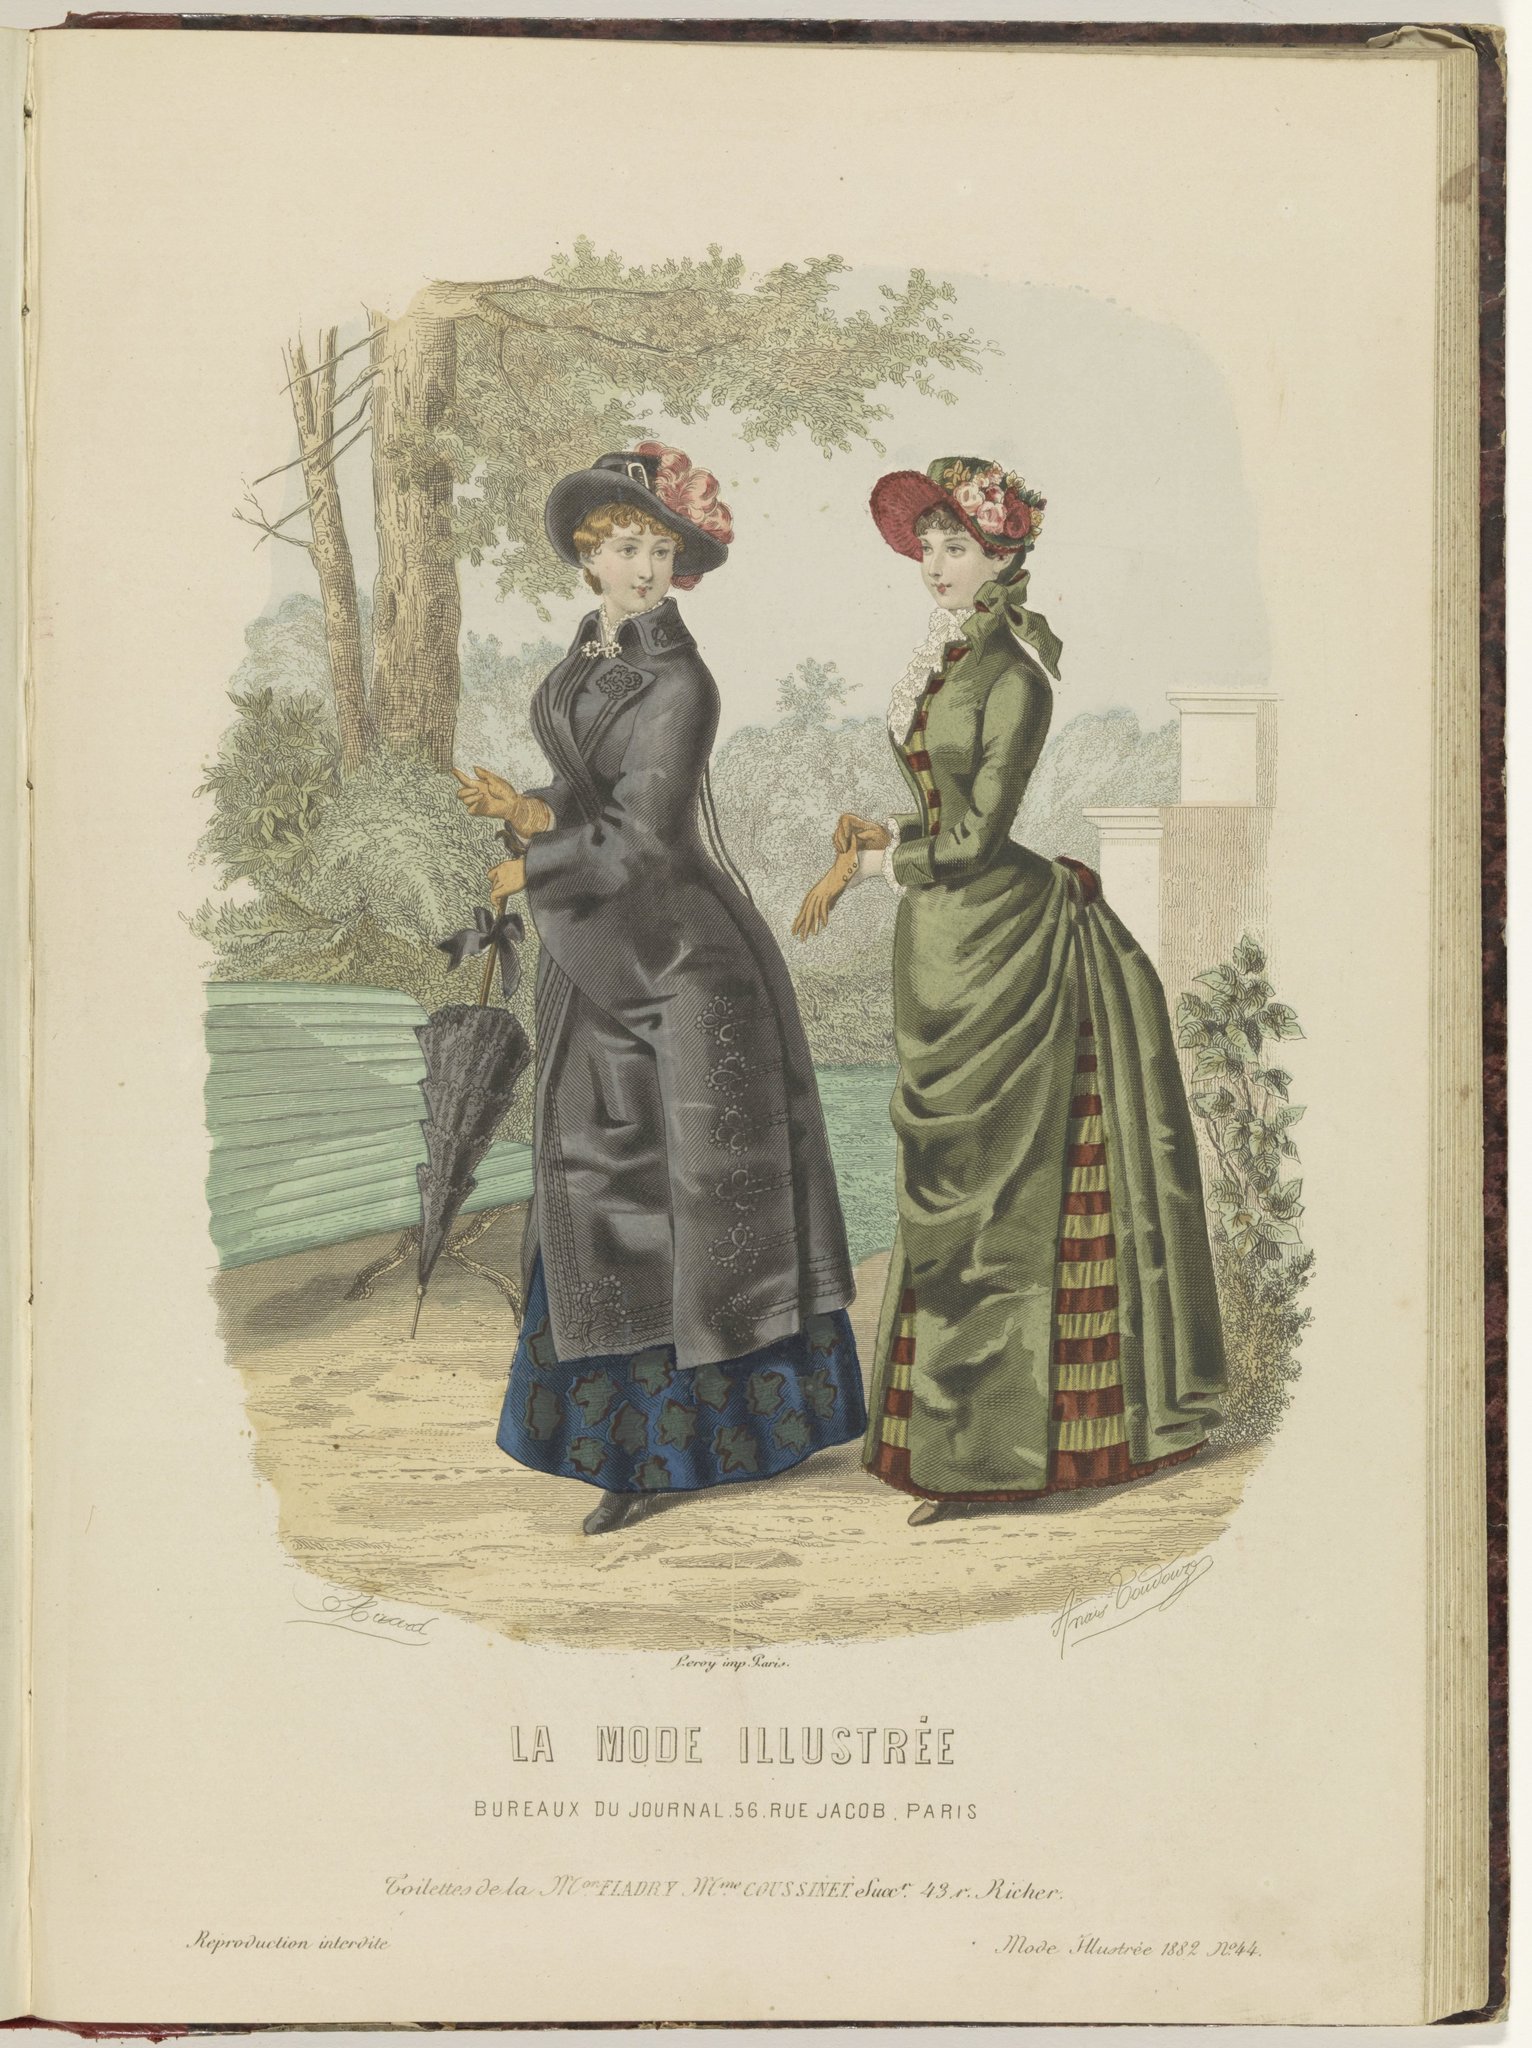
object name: magazine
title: La Mode Illustrée, Journal de la Famille, 1882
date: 1882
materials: paper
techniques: engraving, hand coloring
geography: paris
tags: fashion plates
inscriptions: date